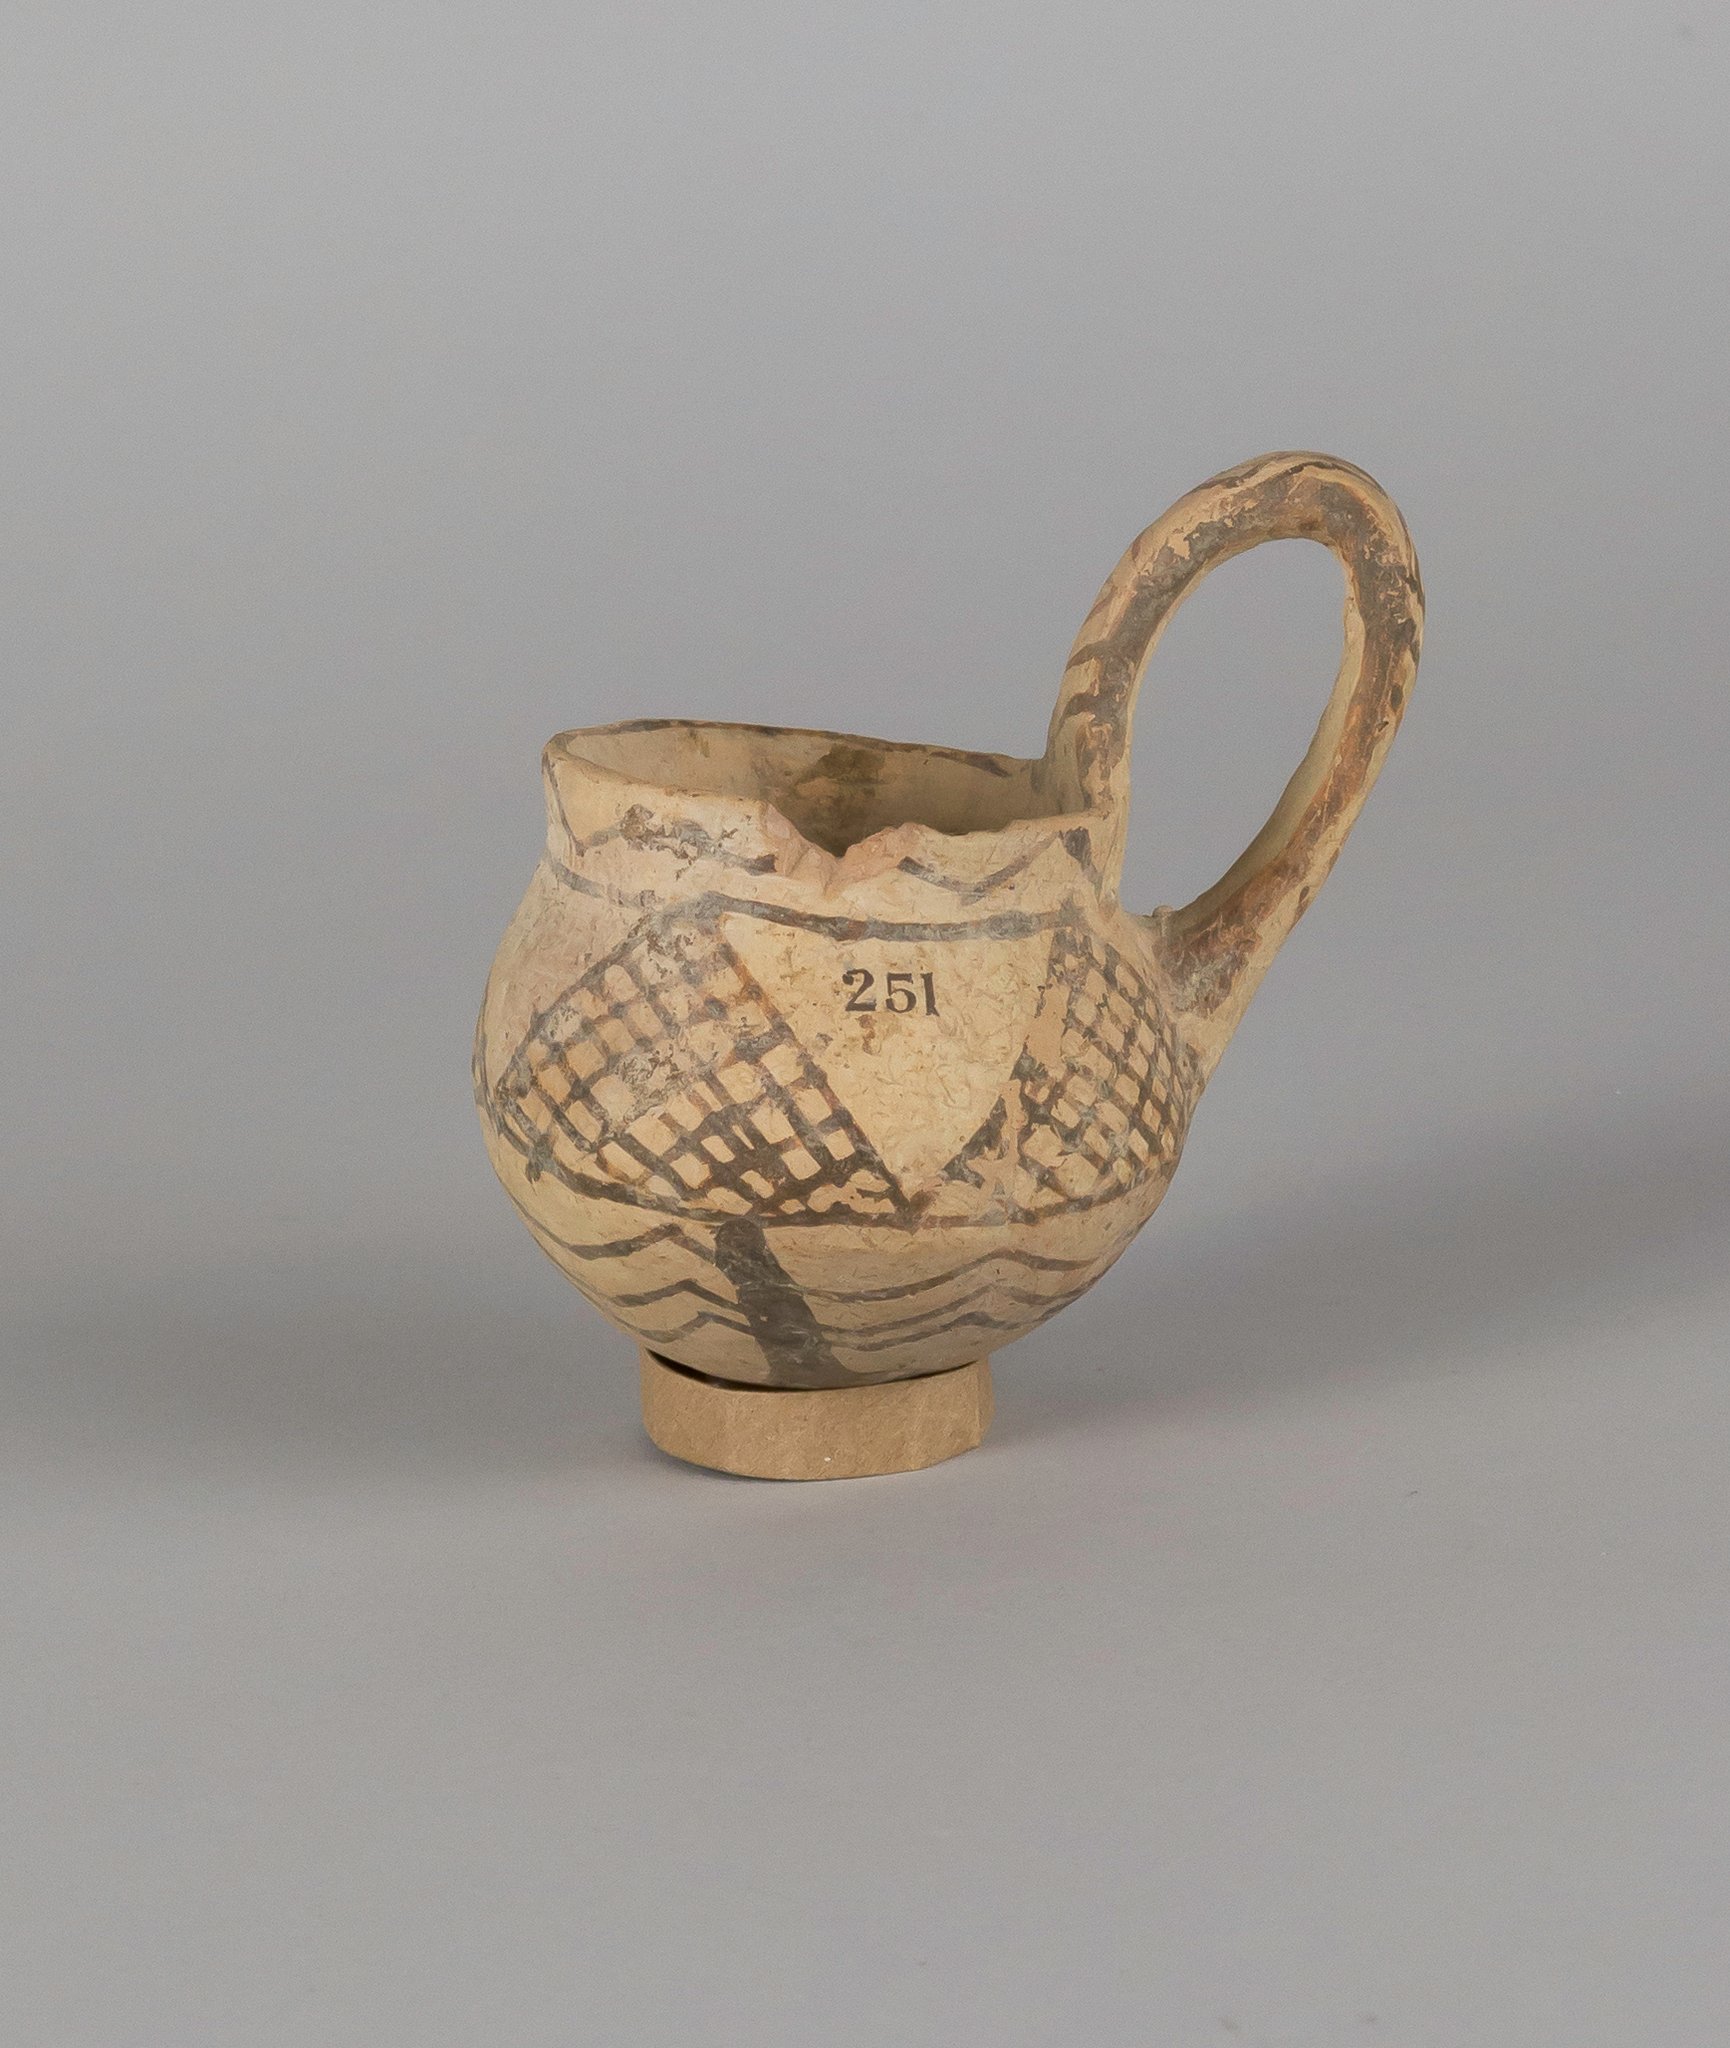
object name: cup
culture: cypriot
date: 3200-1050 BCE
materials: terracotta